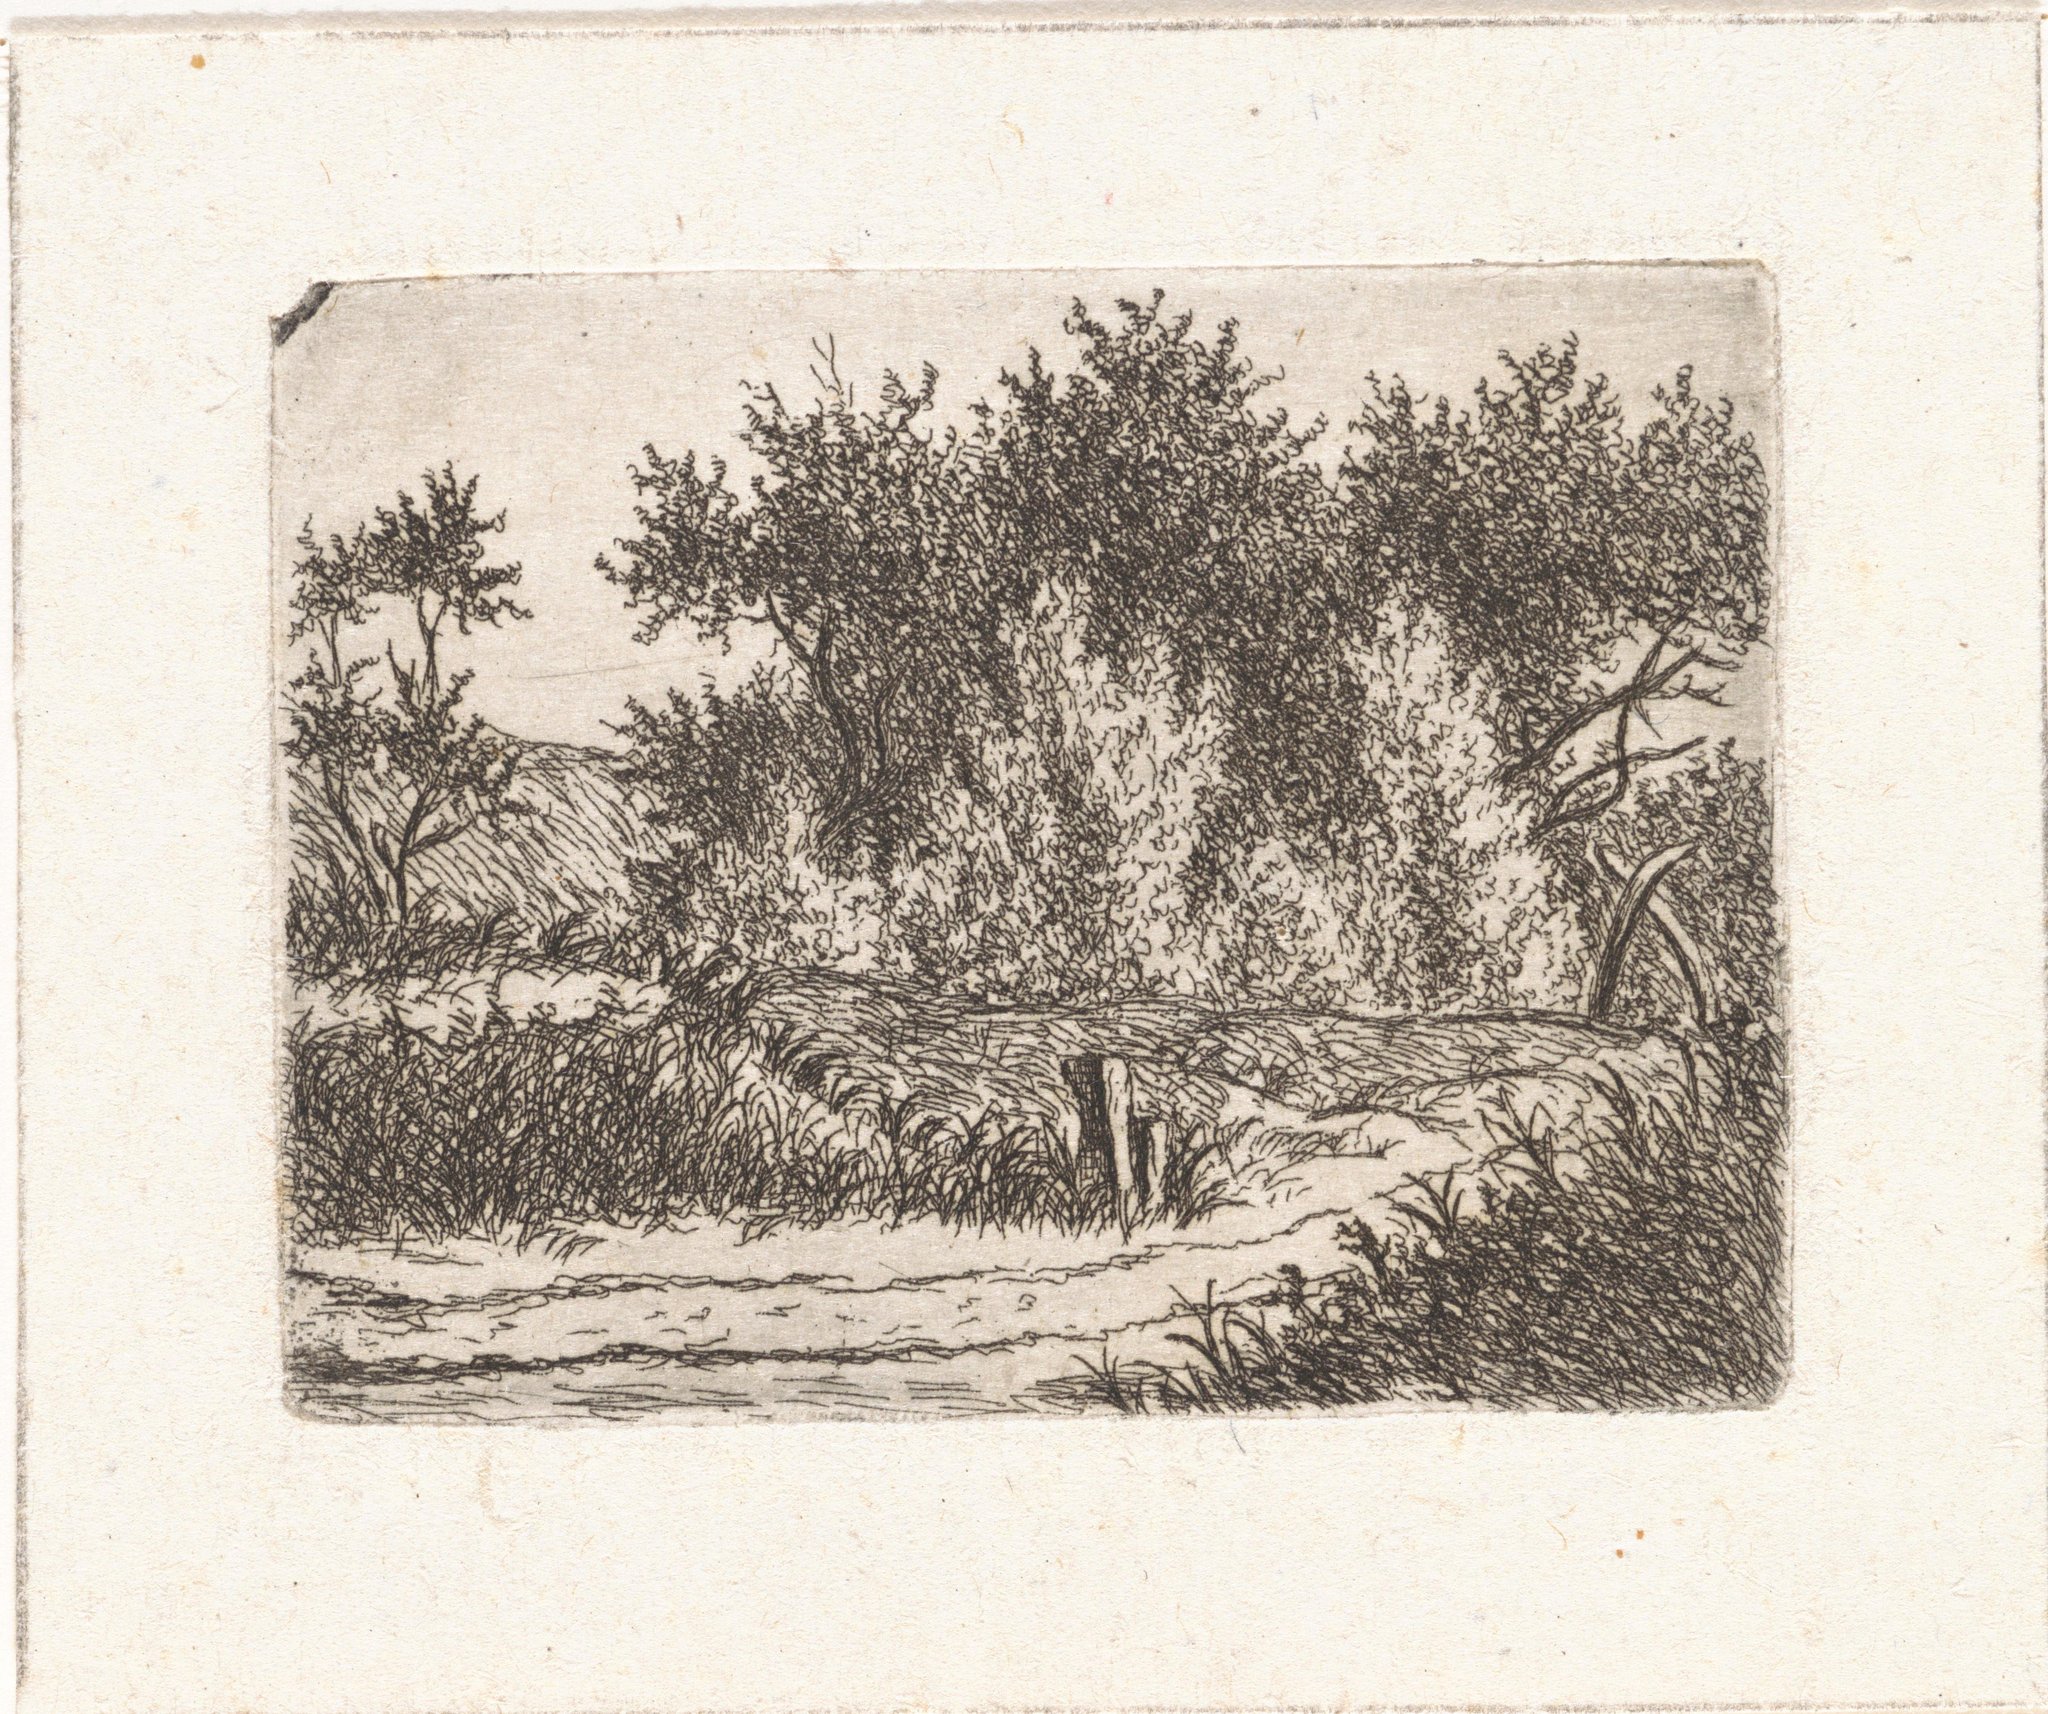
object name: print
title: Bospad met twee palen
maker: abraham hendrik winter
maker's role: painter, print maker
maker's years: 1800-1861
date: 1815-1860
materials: paper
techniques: etching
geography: utrecht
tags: forest path or lane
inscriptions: collector's mark: Lugt 2228